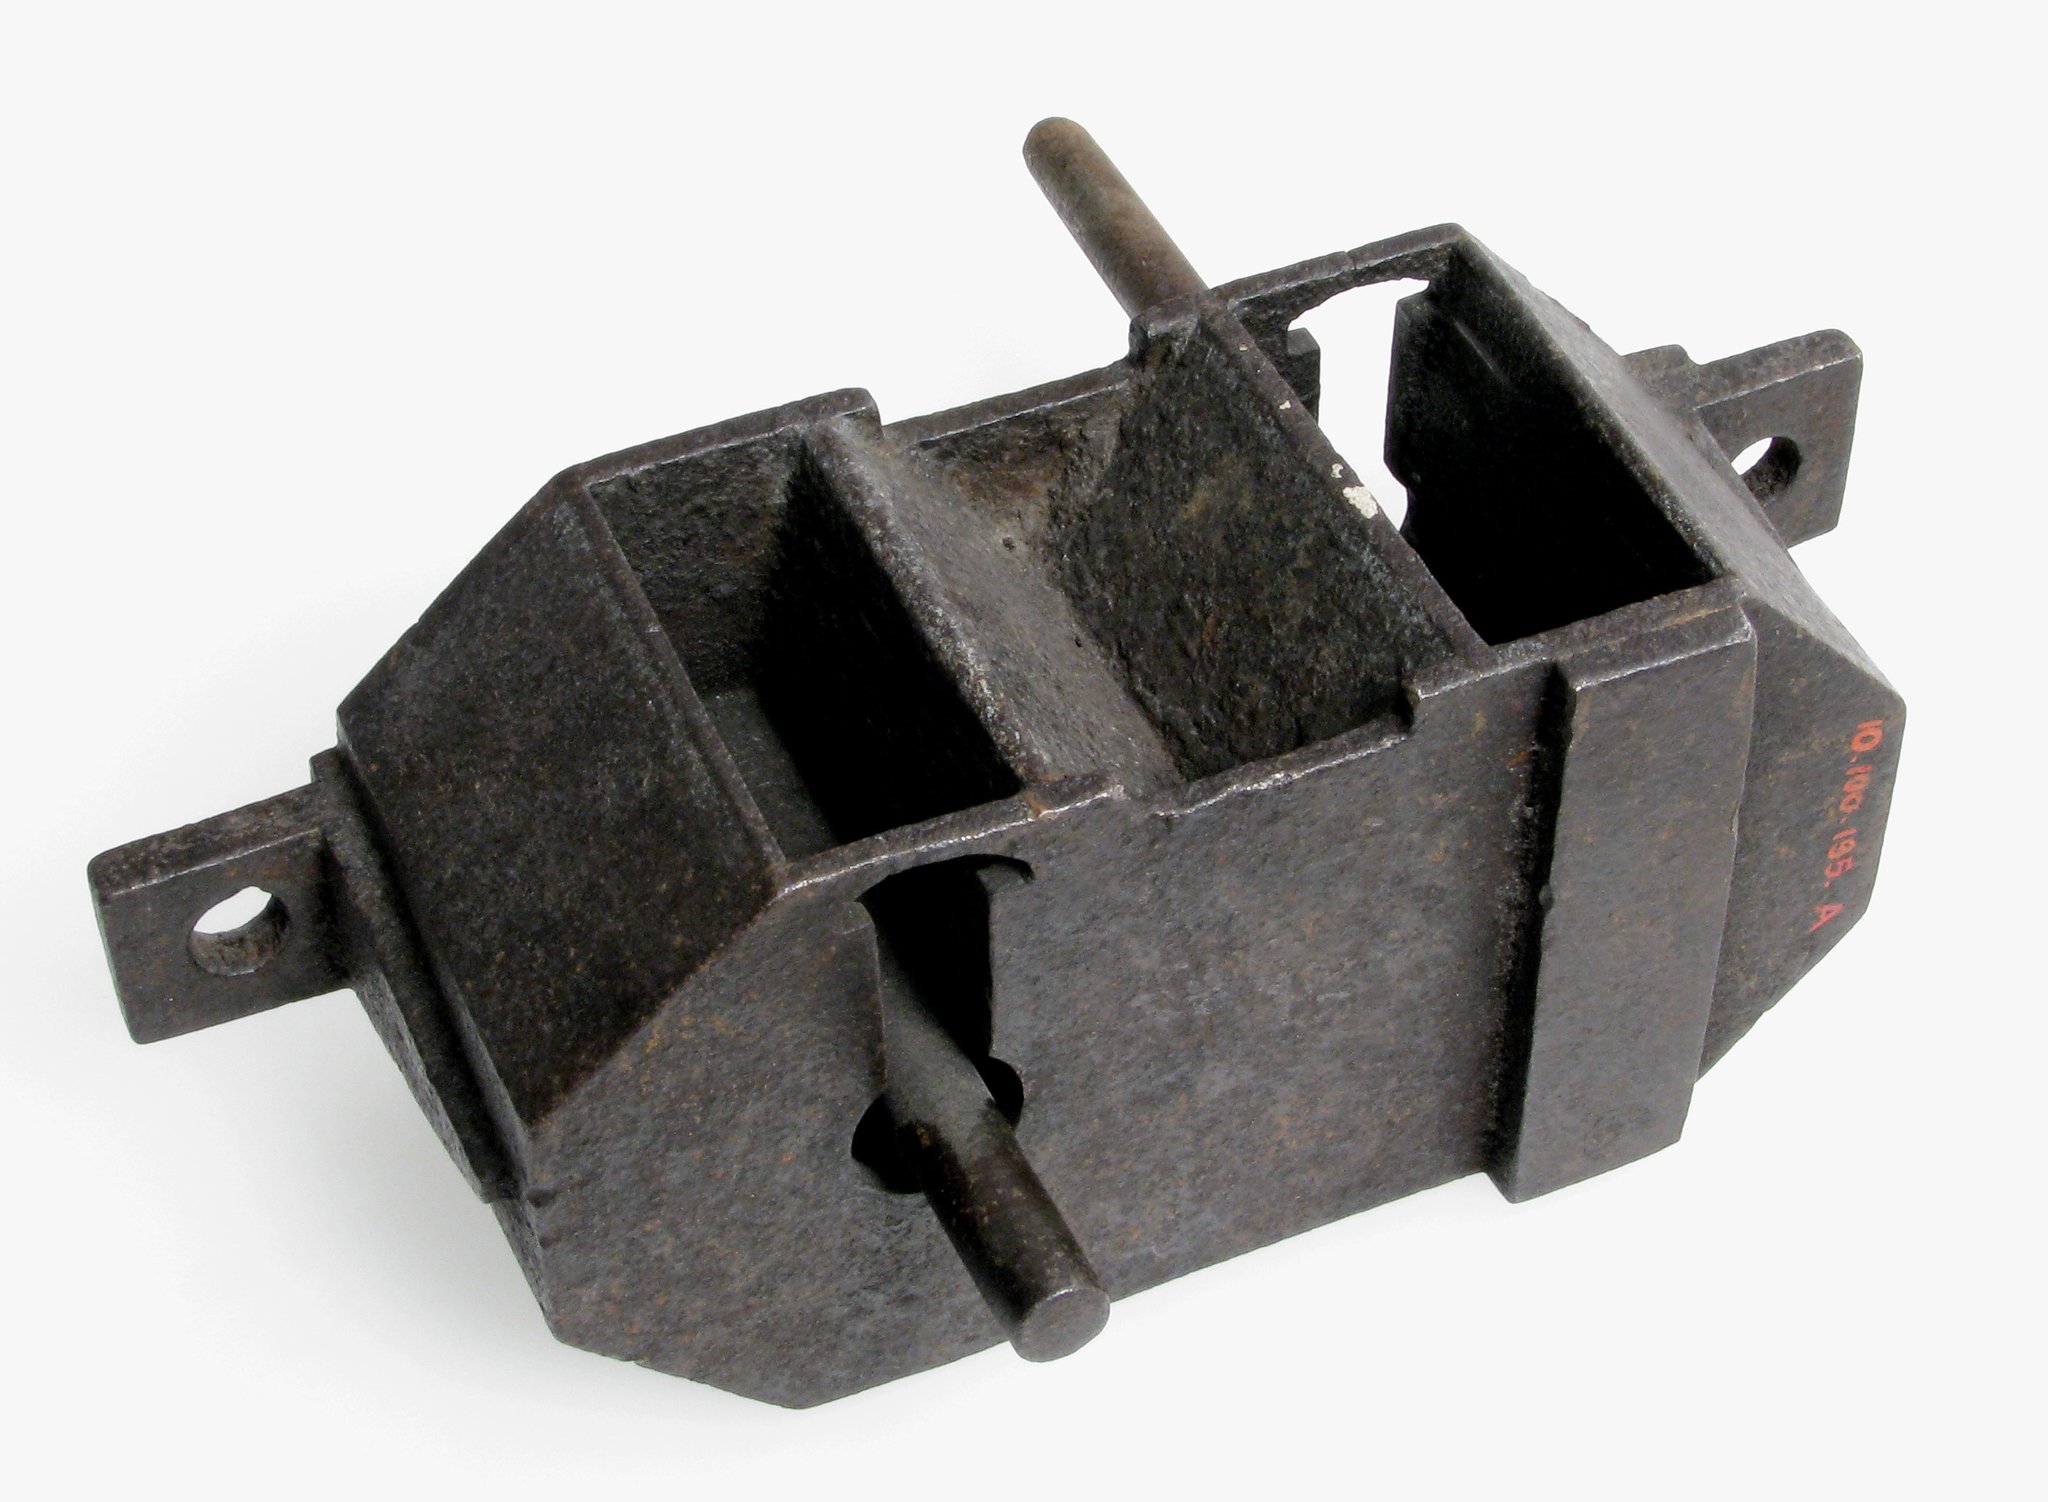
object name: mortise lock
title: Lock, Double-Face Mortise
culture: german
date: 1451-1500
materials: iron